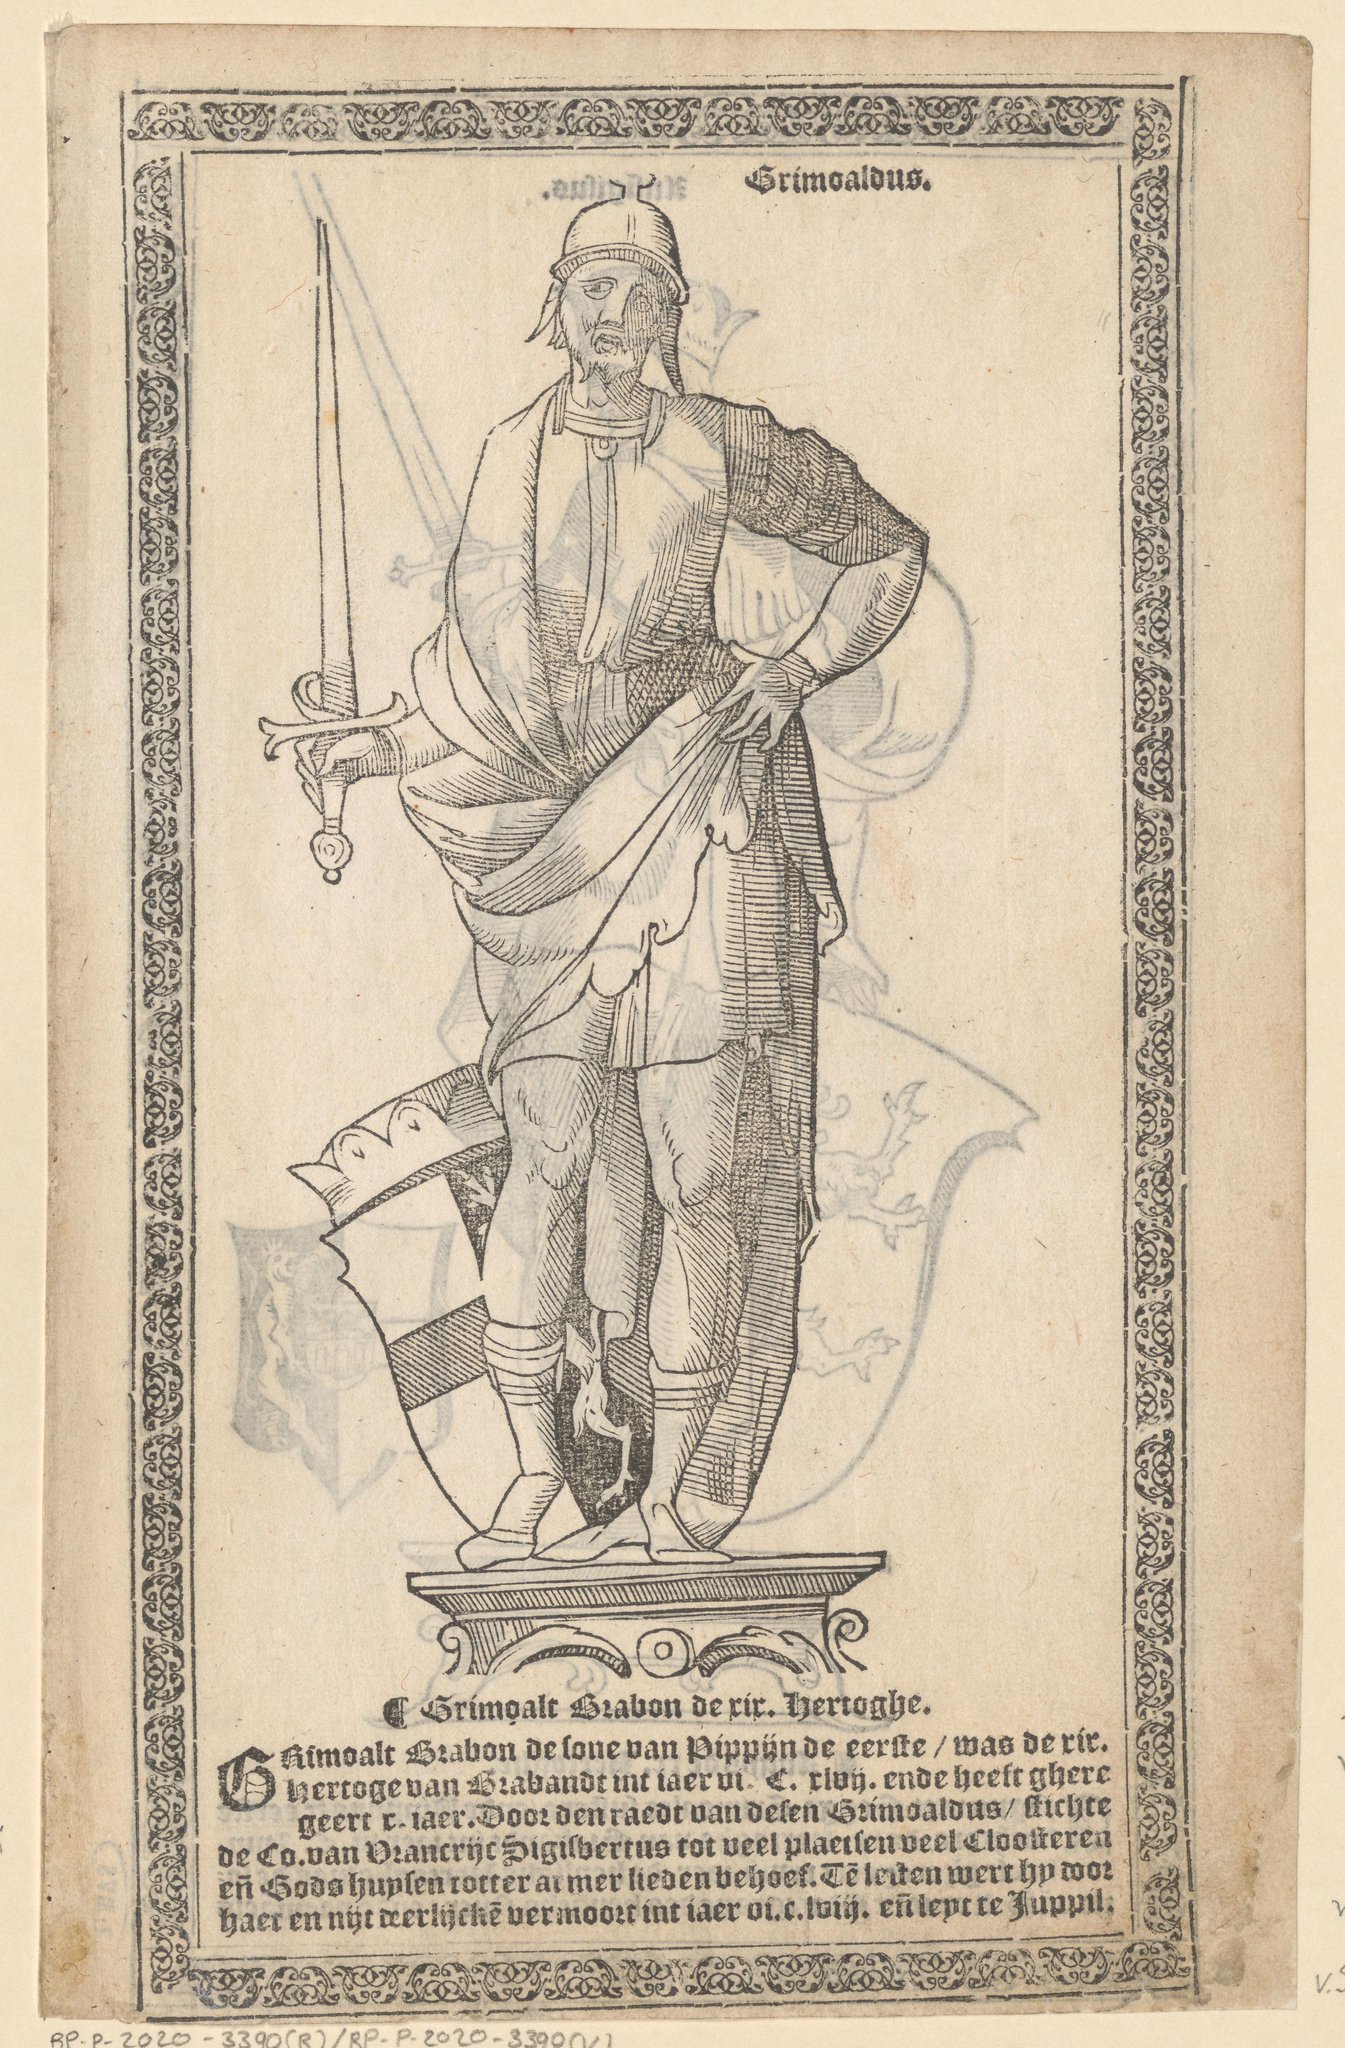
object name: book illustration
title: Portret van Grimoald I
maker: jan molijns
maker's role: print maker, publisher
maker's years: 1498-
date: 1565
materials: paper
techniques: letterpress printing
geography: antwerp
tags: helmet, historical persons, hacking and thrusting weapons: sword, armorial bearing, heraldry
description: Prent uit: Dit is die afcoemste ende genalogie der hertoghen ende hertoginnen van Brabandt, (...). Antwerpen: Jan Molijns, 1565.